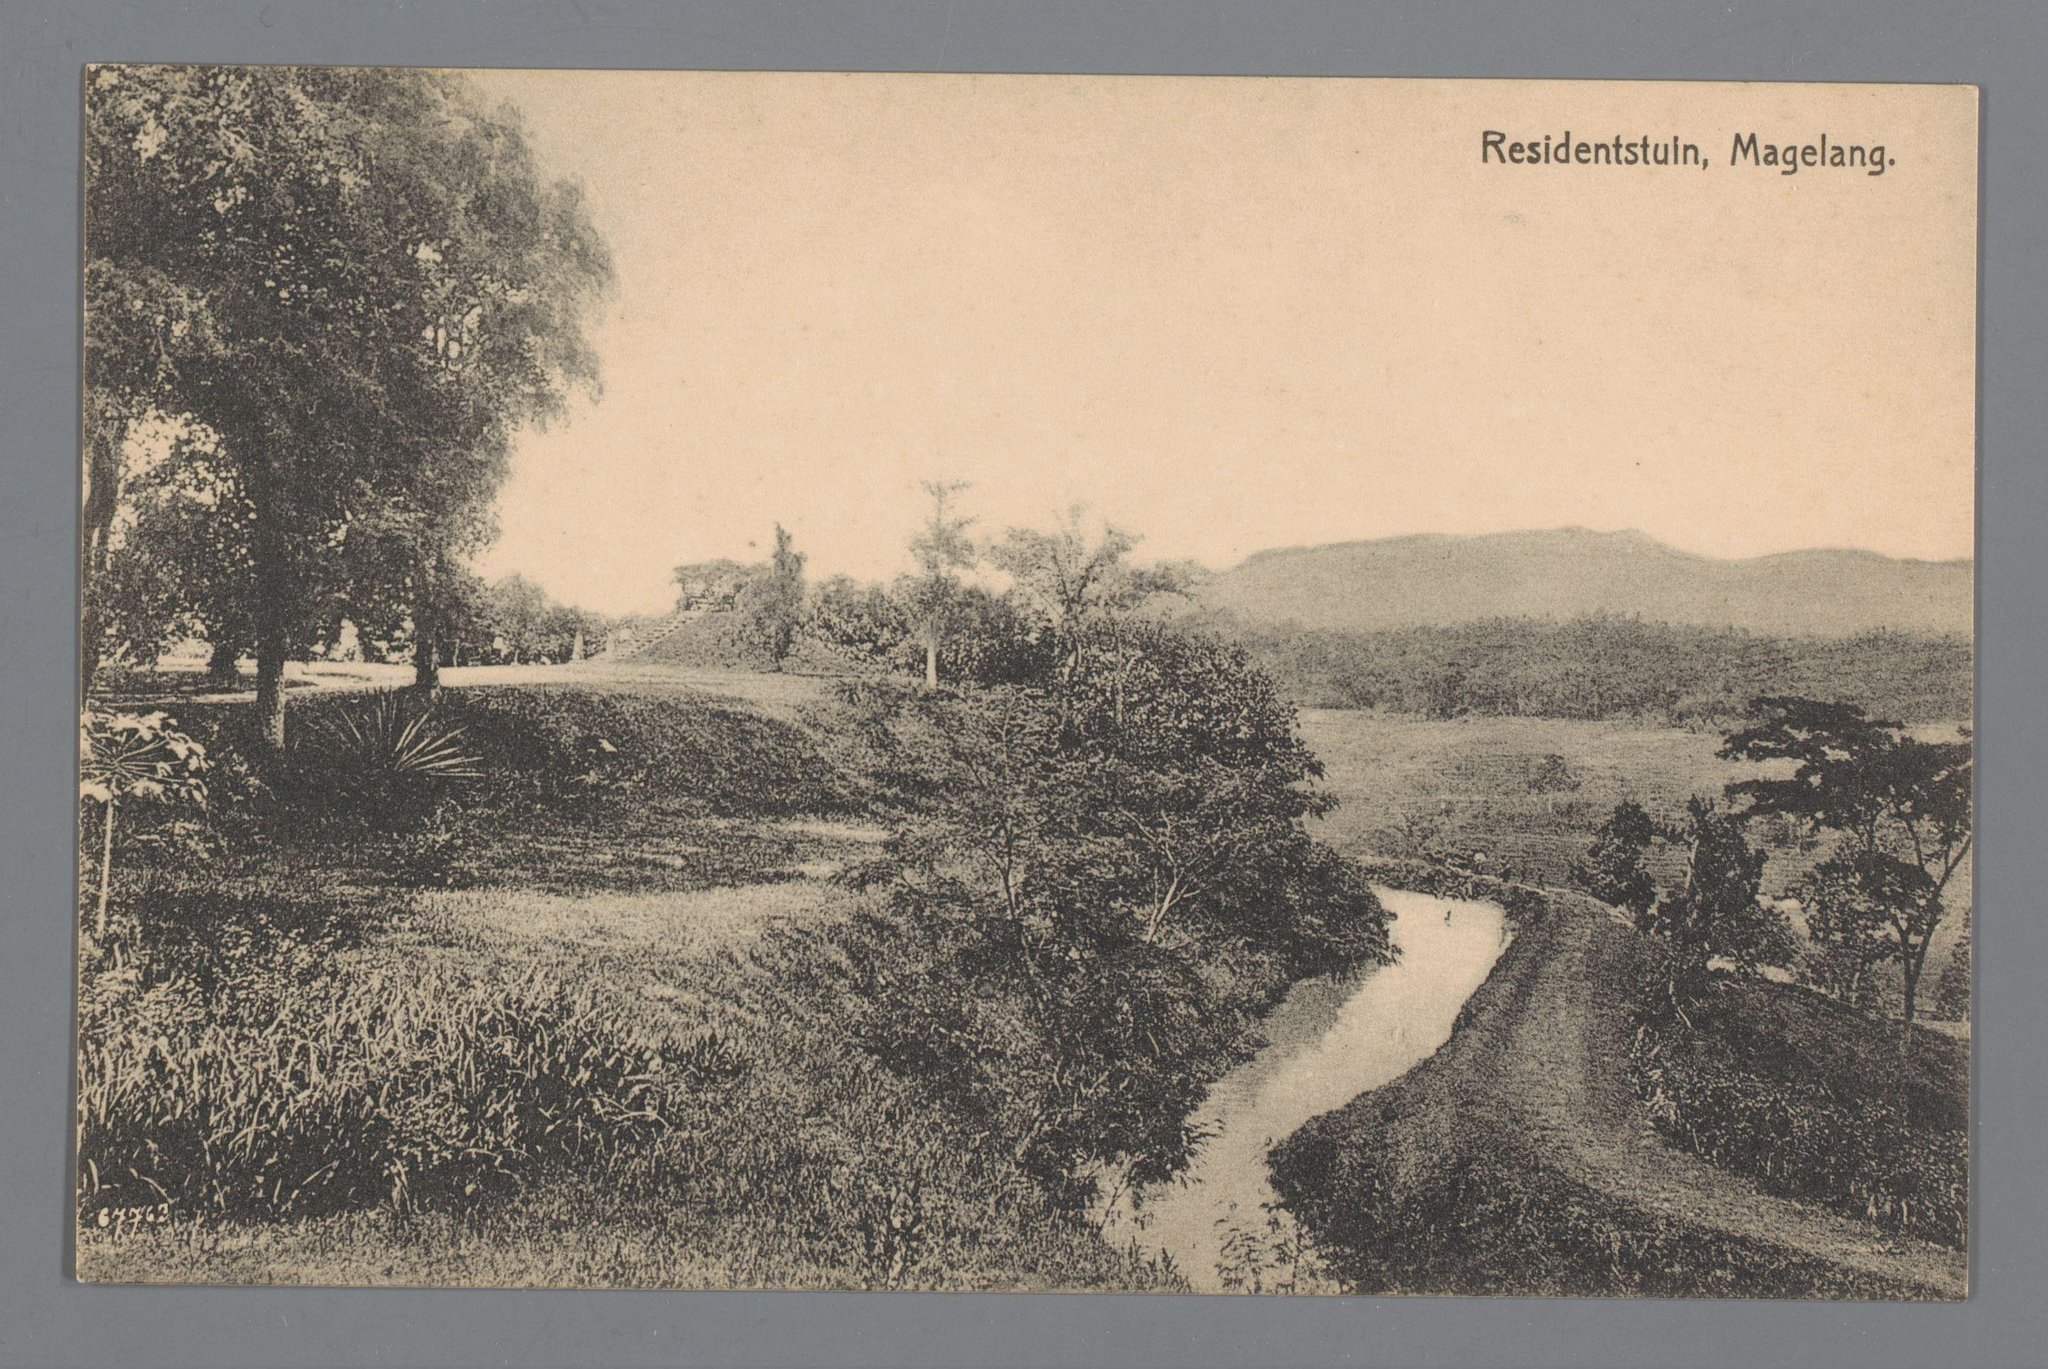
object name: photograph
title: Residentstuin, Magelang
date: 1900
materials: paper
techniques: photography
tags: dutch east indies, the